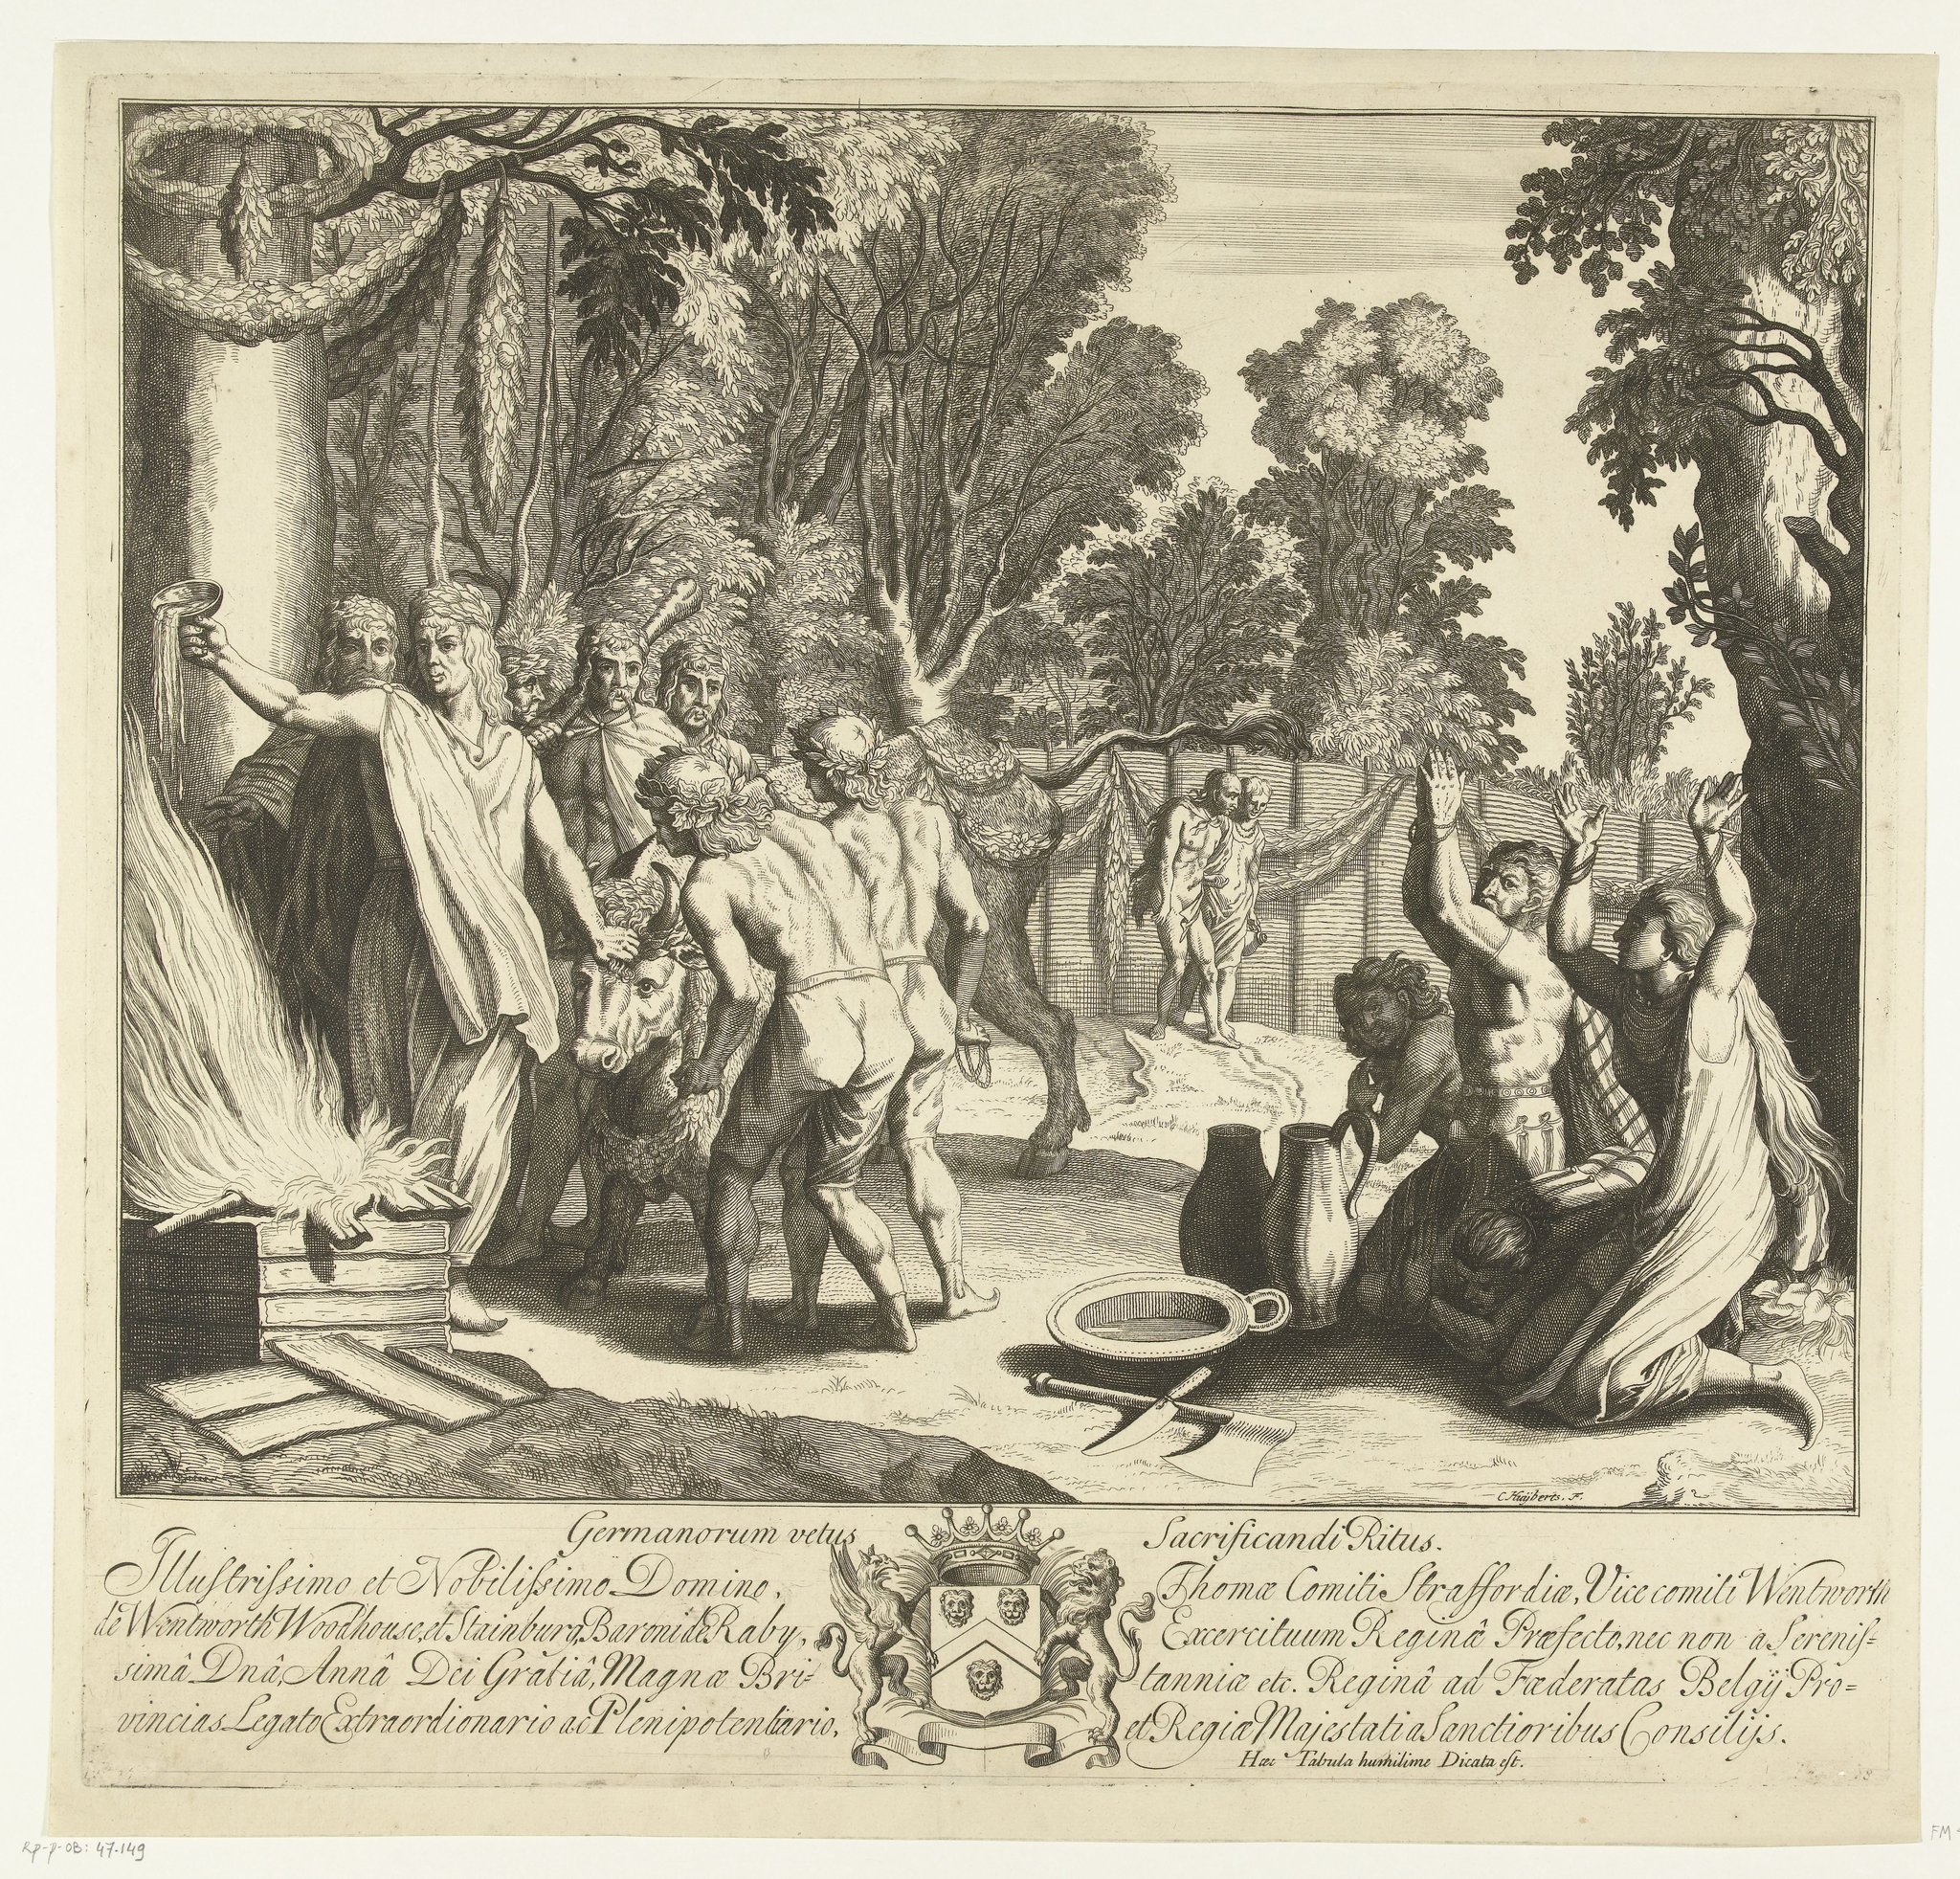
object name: history print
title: Germaans offer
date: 1700-1709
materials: paper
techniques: etching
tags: extinct, 'historical' peoples (with name), sacrifice ~ germanic and scandinavian religions, netherlands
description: Offerceremonie bij de Germanen. Een priester giet een vloeistof in het vuur, een rund wordt klaar gehouden voor het offer. Rechts knielen toeschouwers met geheven armen.